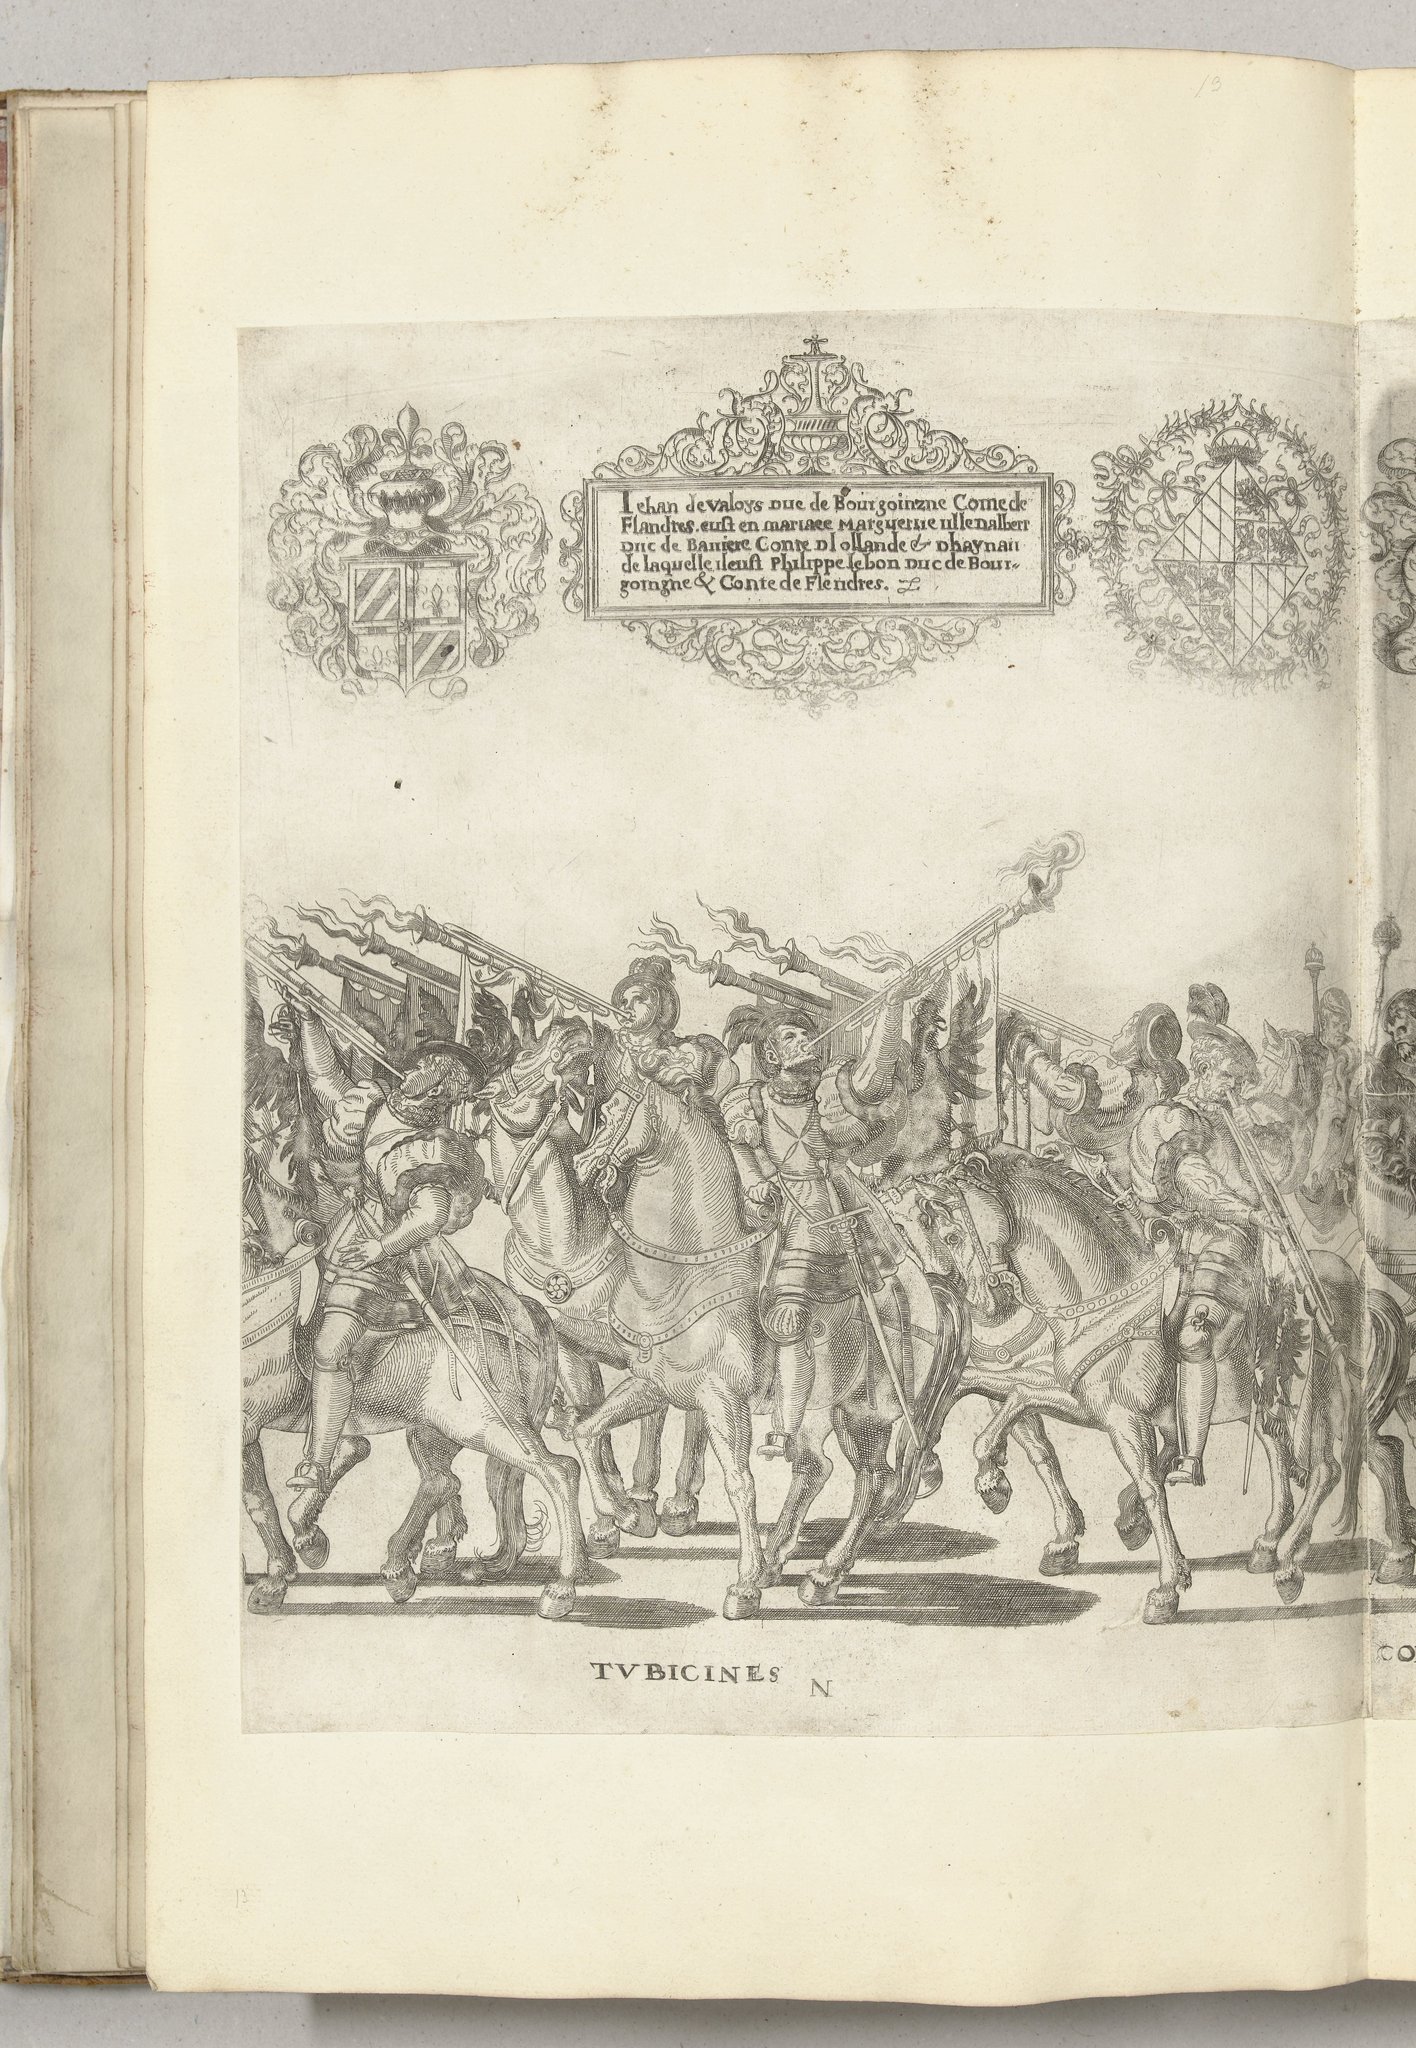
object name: print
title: Bazuinen, plaat N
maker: nicolaas hogenberg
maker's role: draughtsman, painter, print maker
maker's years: 1500-1539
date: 1530-1536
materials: paper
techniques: etching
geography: mechelen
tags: charles v (holy roman emperor and king of spain), rome, festivities (+ parade, pageant, cavalcade ~ festive activities)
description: Prent in het album waarin zijn ingeplakt de 40 platen die achterelkaar samen het fries vormen van de optocht van Karel V met de paus Clemens VII te Bologna na zijn kroning tot keizer, 24 februari 1530.